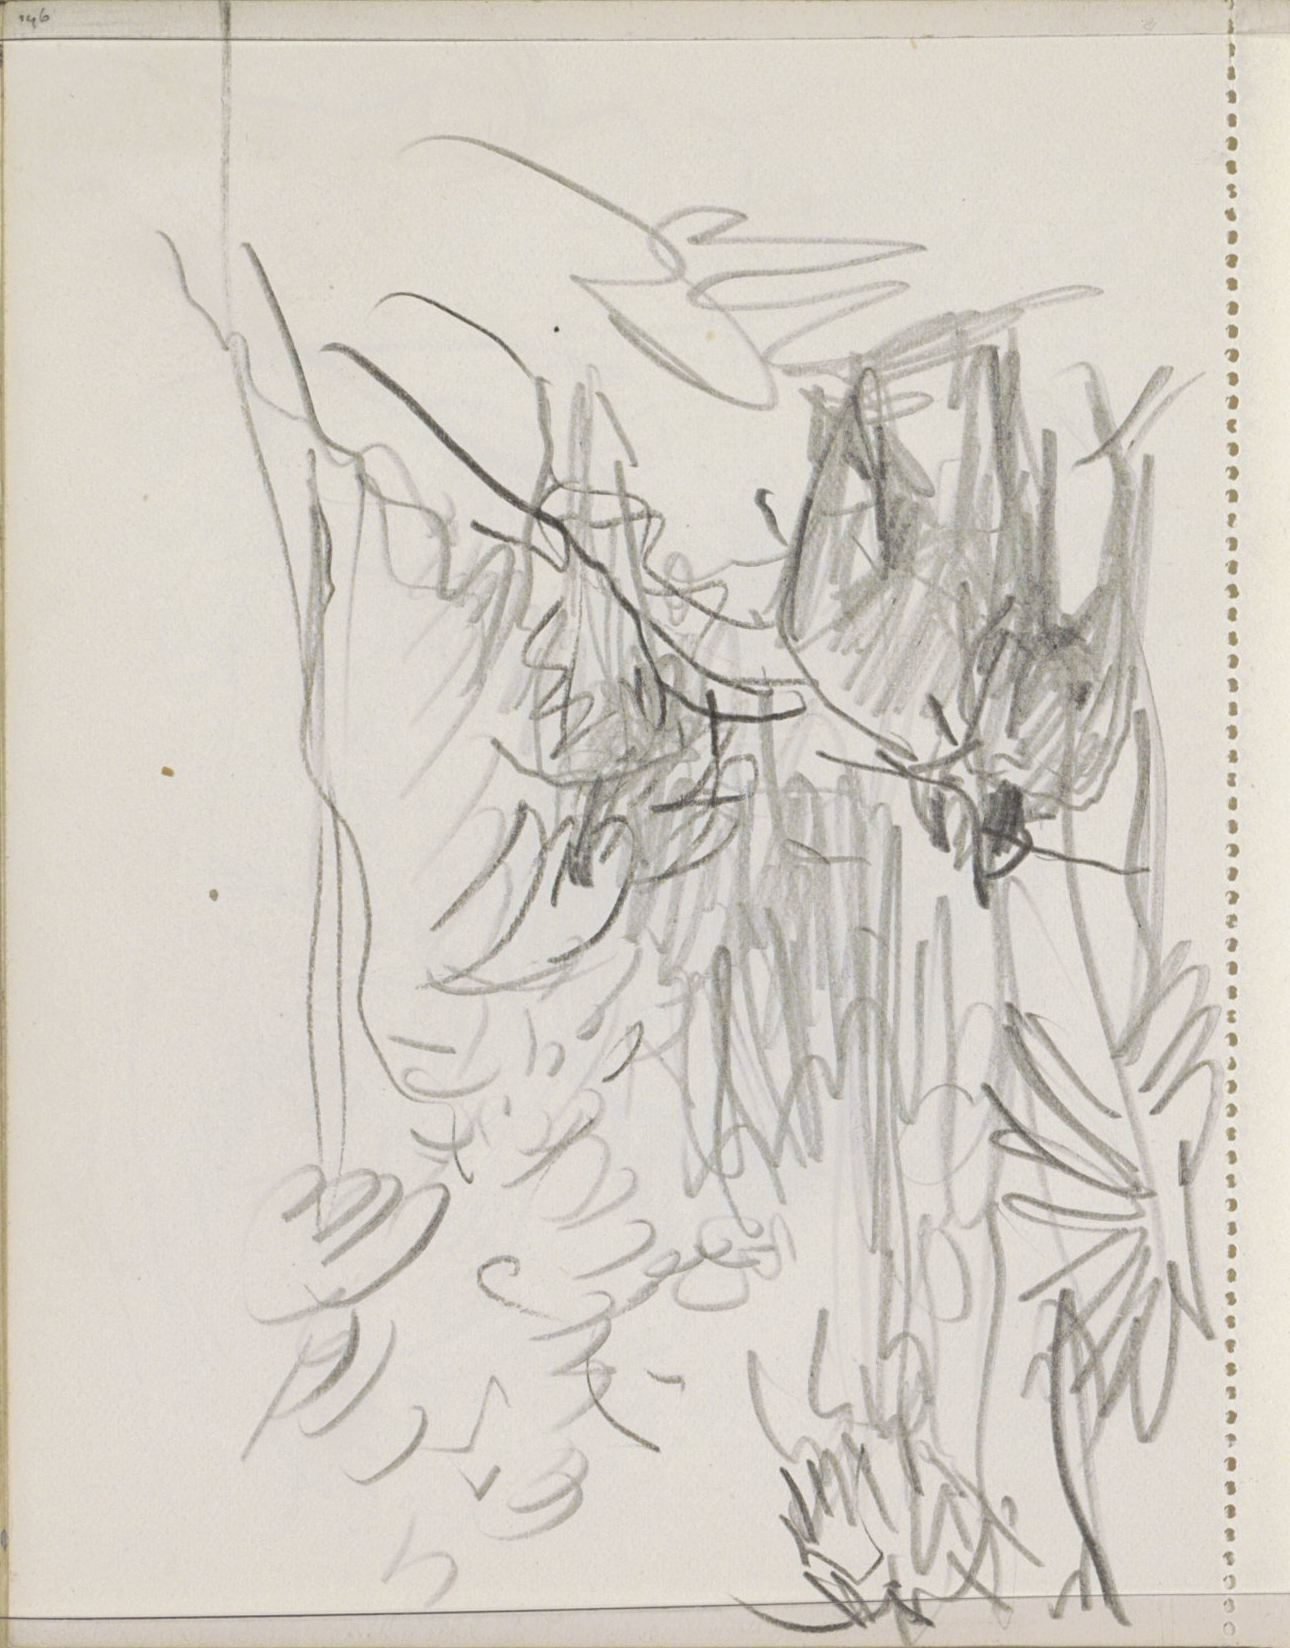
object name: sketchbook leaf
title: Olifant in het oerwoud van India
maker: marius bauer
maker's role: draughtsman, print maker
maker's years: 1867-1932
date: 1924-1925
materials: paper, pencil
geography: india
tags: jungle, trunked animals: elephant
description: Pagina 146 uit een schetsboek met 75 bladen.